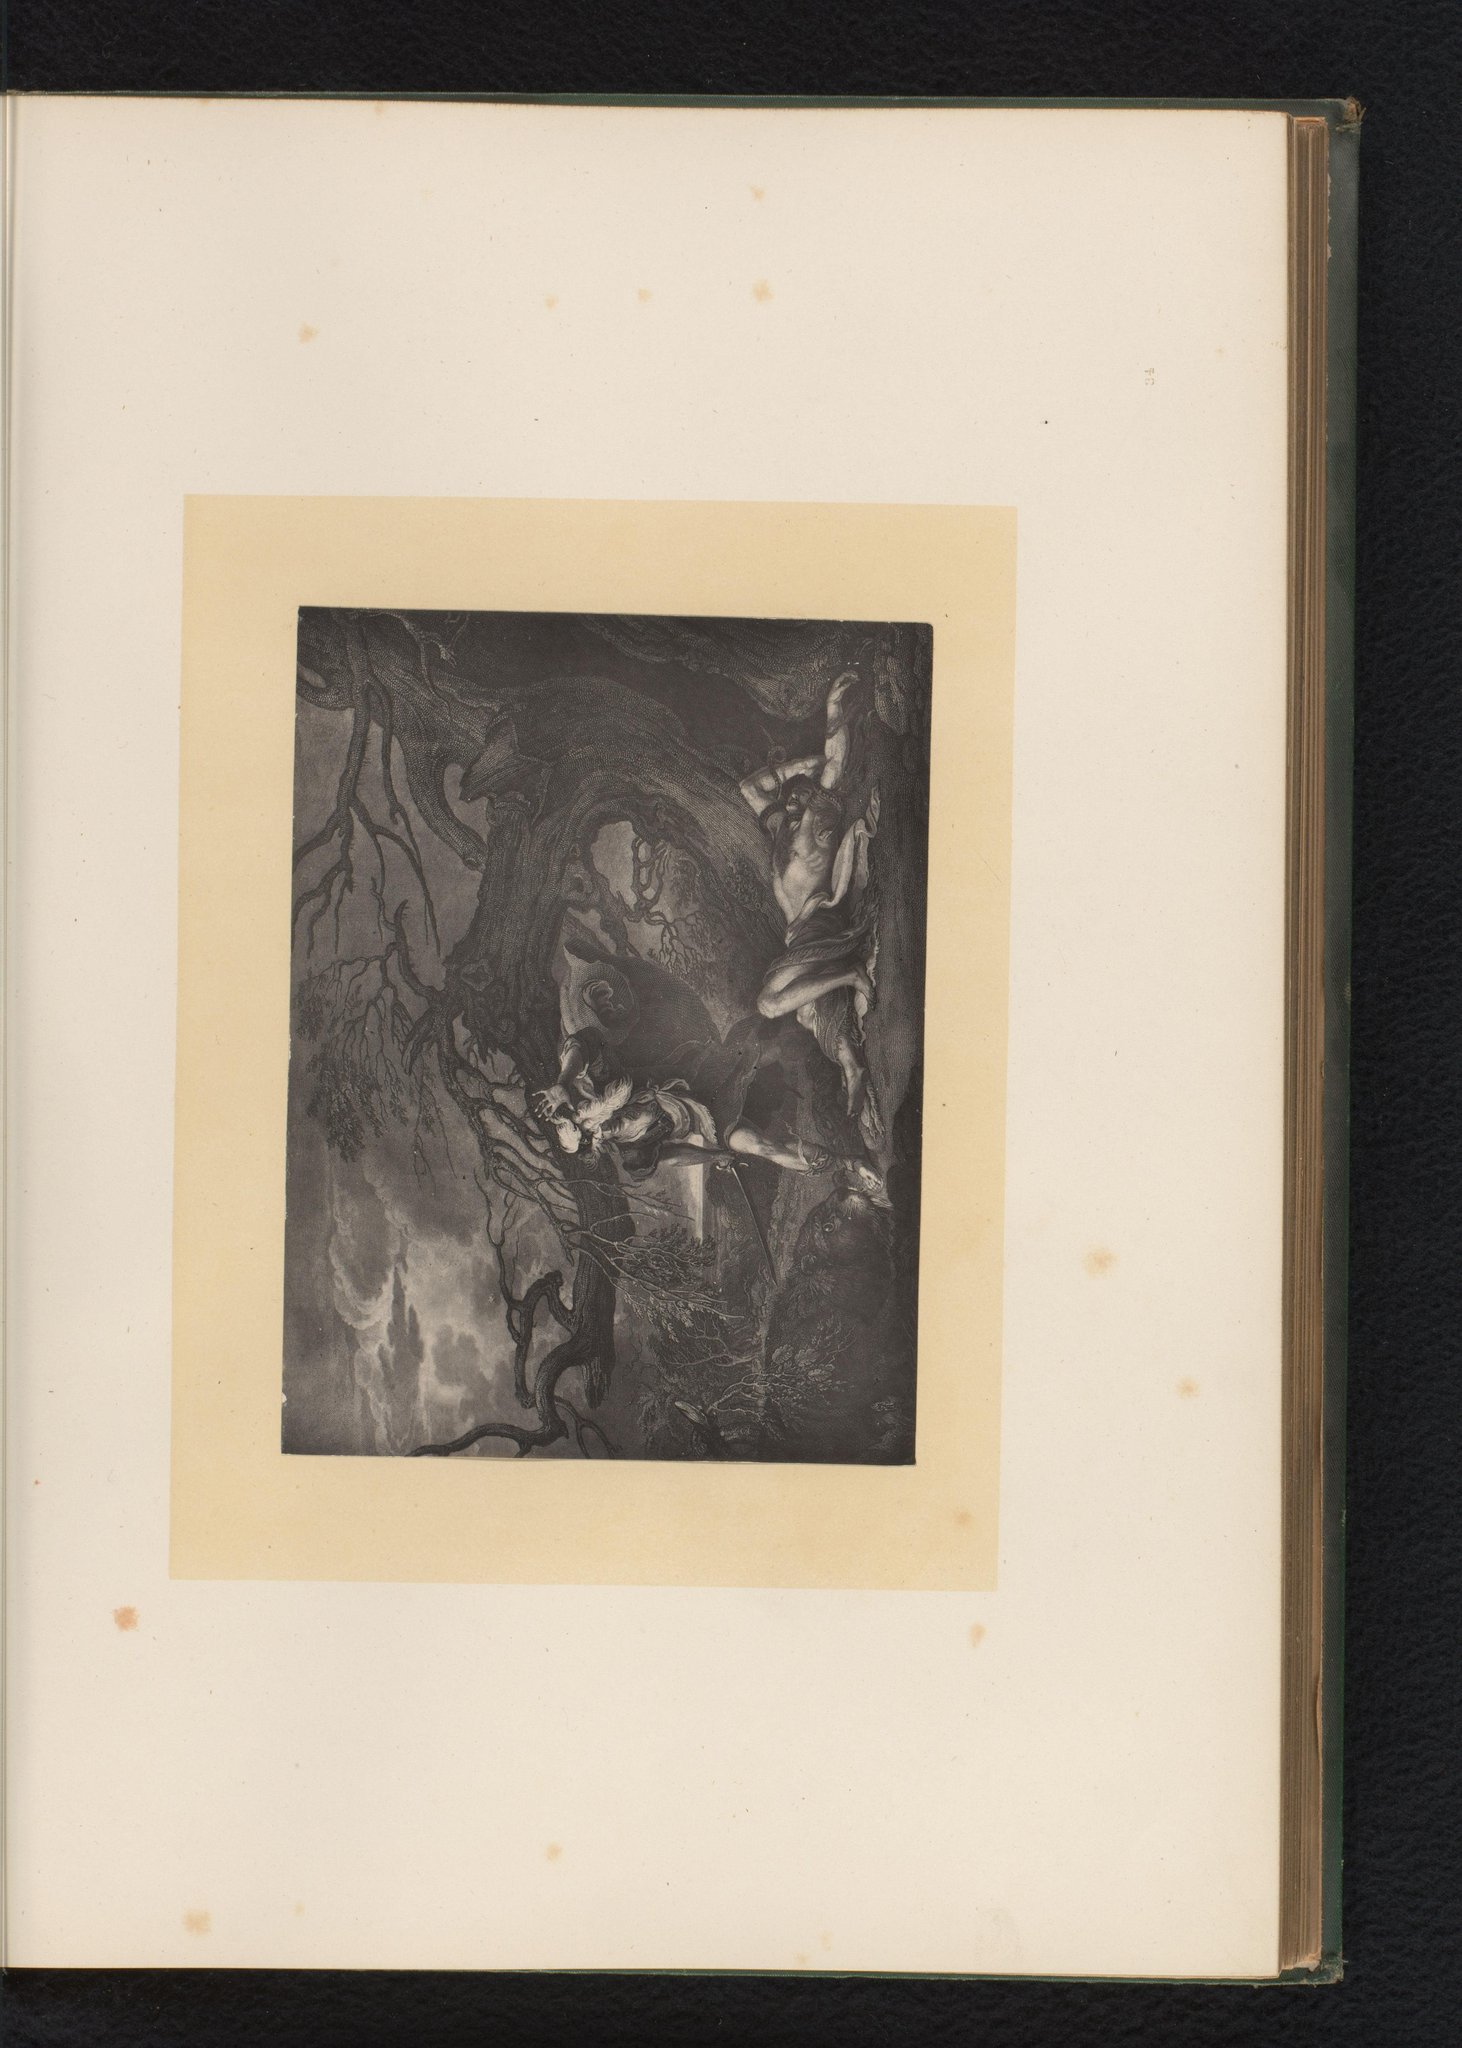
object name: reproduction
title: Reproductie van een gravure naar een schilderij van een scène uit As You Like It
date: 1874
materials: paper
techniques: woodburytype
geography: london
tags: (shakespeare, as you like it) specific works of literature (with author, title)